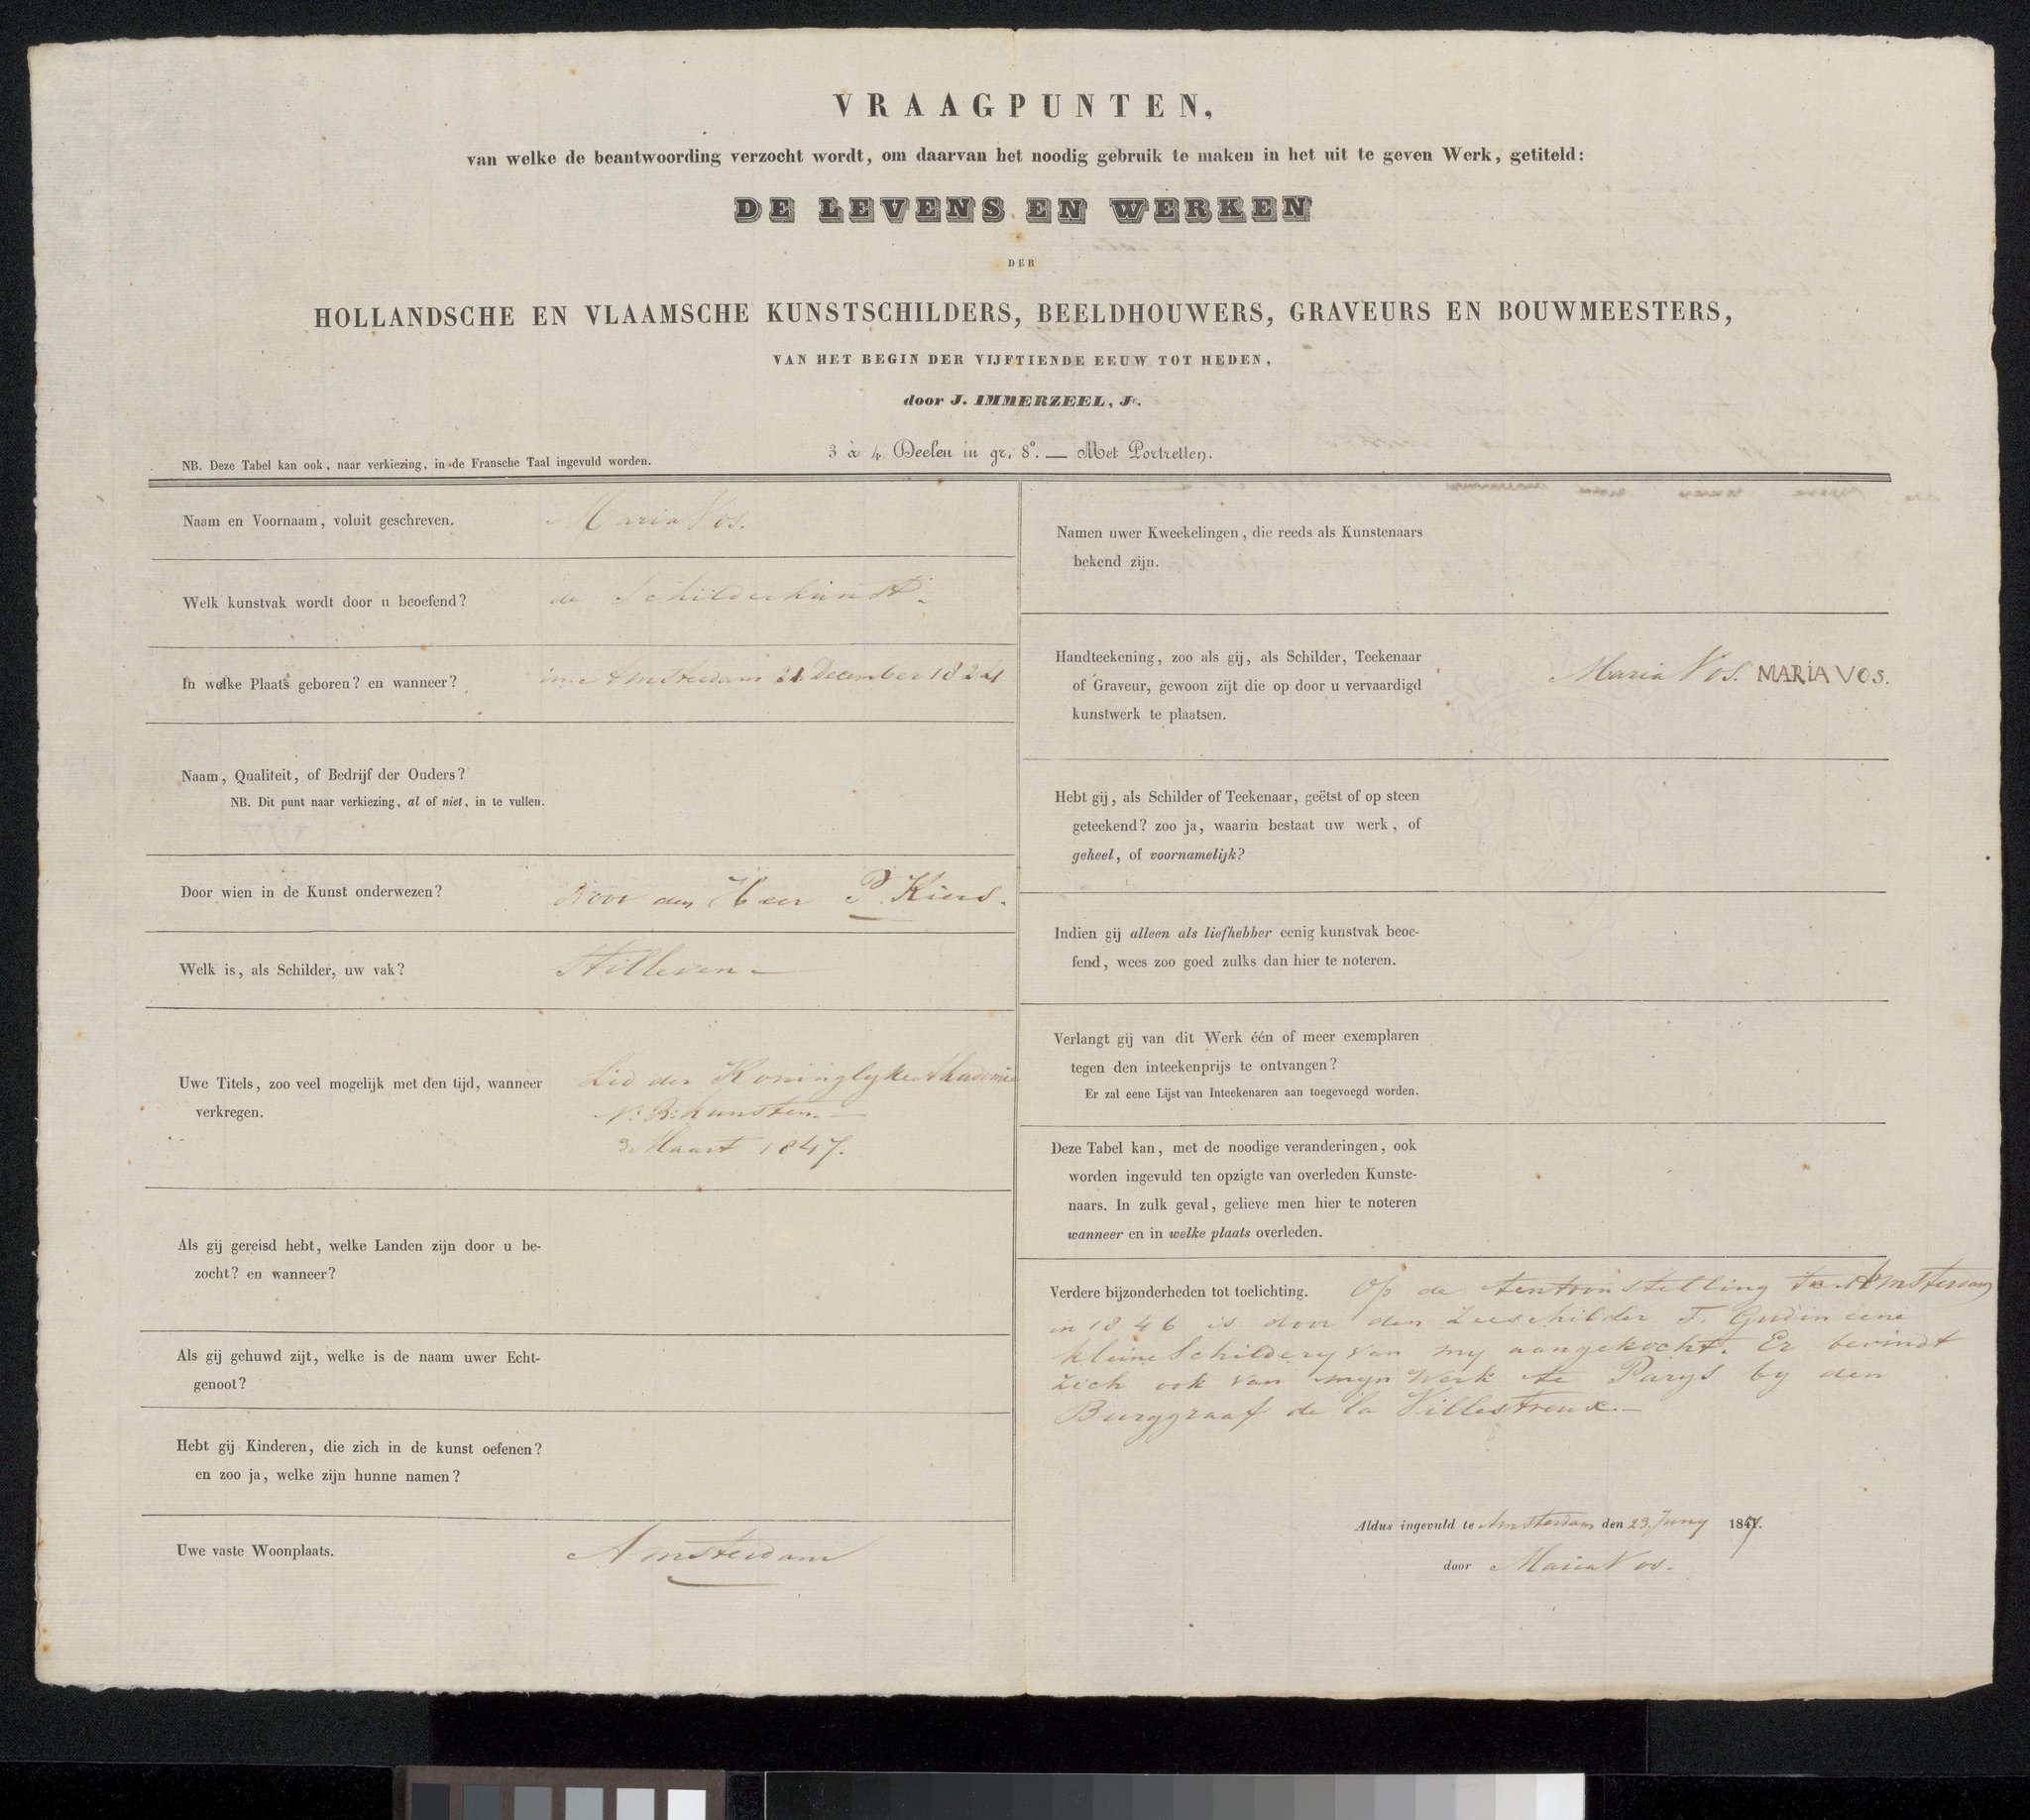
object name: manuscript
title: Enquêteformulier ingevuld door Maria Vos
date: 1847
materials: ink, paper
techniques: pen, printing, writing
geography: amsterdam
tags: painter, print maker, draughtsman, maria vos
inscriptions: watermark, inscription: ‘Vraagpunten,/ van welke de beantwoording verzocht wordt, om daarvan het noodig gebruik te maken in het uit te geven Werk, getiteld: De levens en werken/ der Hollandsche en Vlaamsche kunstschilders, beeldhouwers,/ graveurs en bouwmeesters, van het begin der vijftiende eeuw tot heden/ door J. Immerzeel, Jr.’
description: Bedoeld voor: Immerzeel, J. Jr., De levens en werken der Hollandsche en Vlaamsche kunstschilders, beeldhouwers, graveurs en bouwmeesters, van het begin der vijftiende eeuw tot heden, Amsterdam: J.C. van Kesteren, 1842-1843.